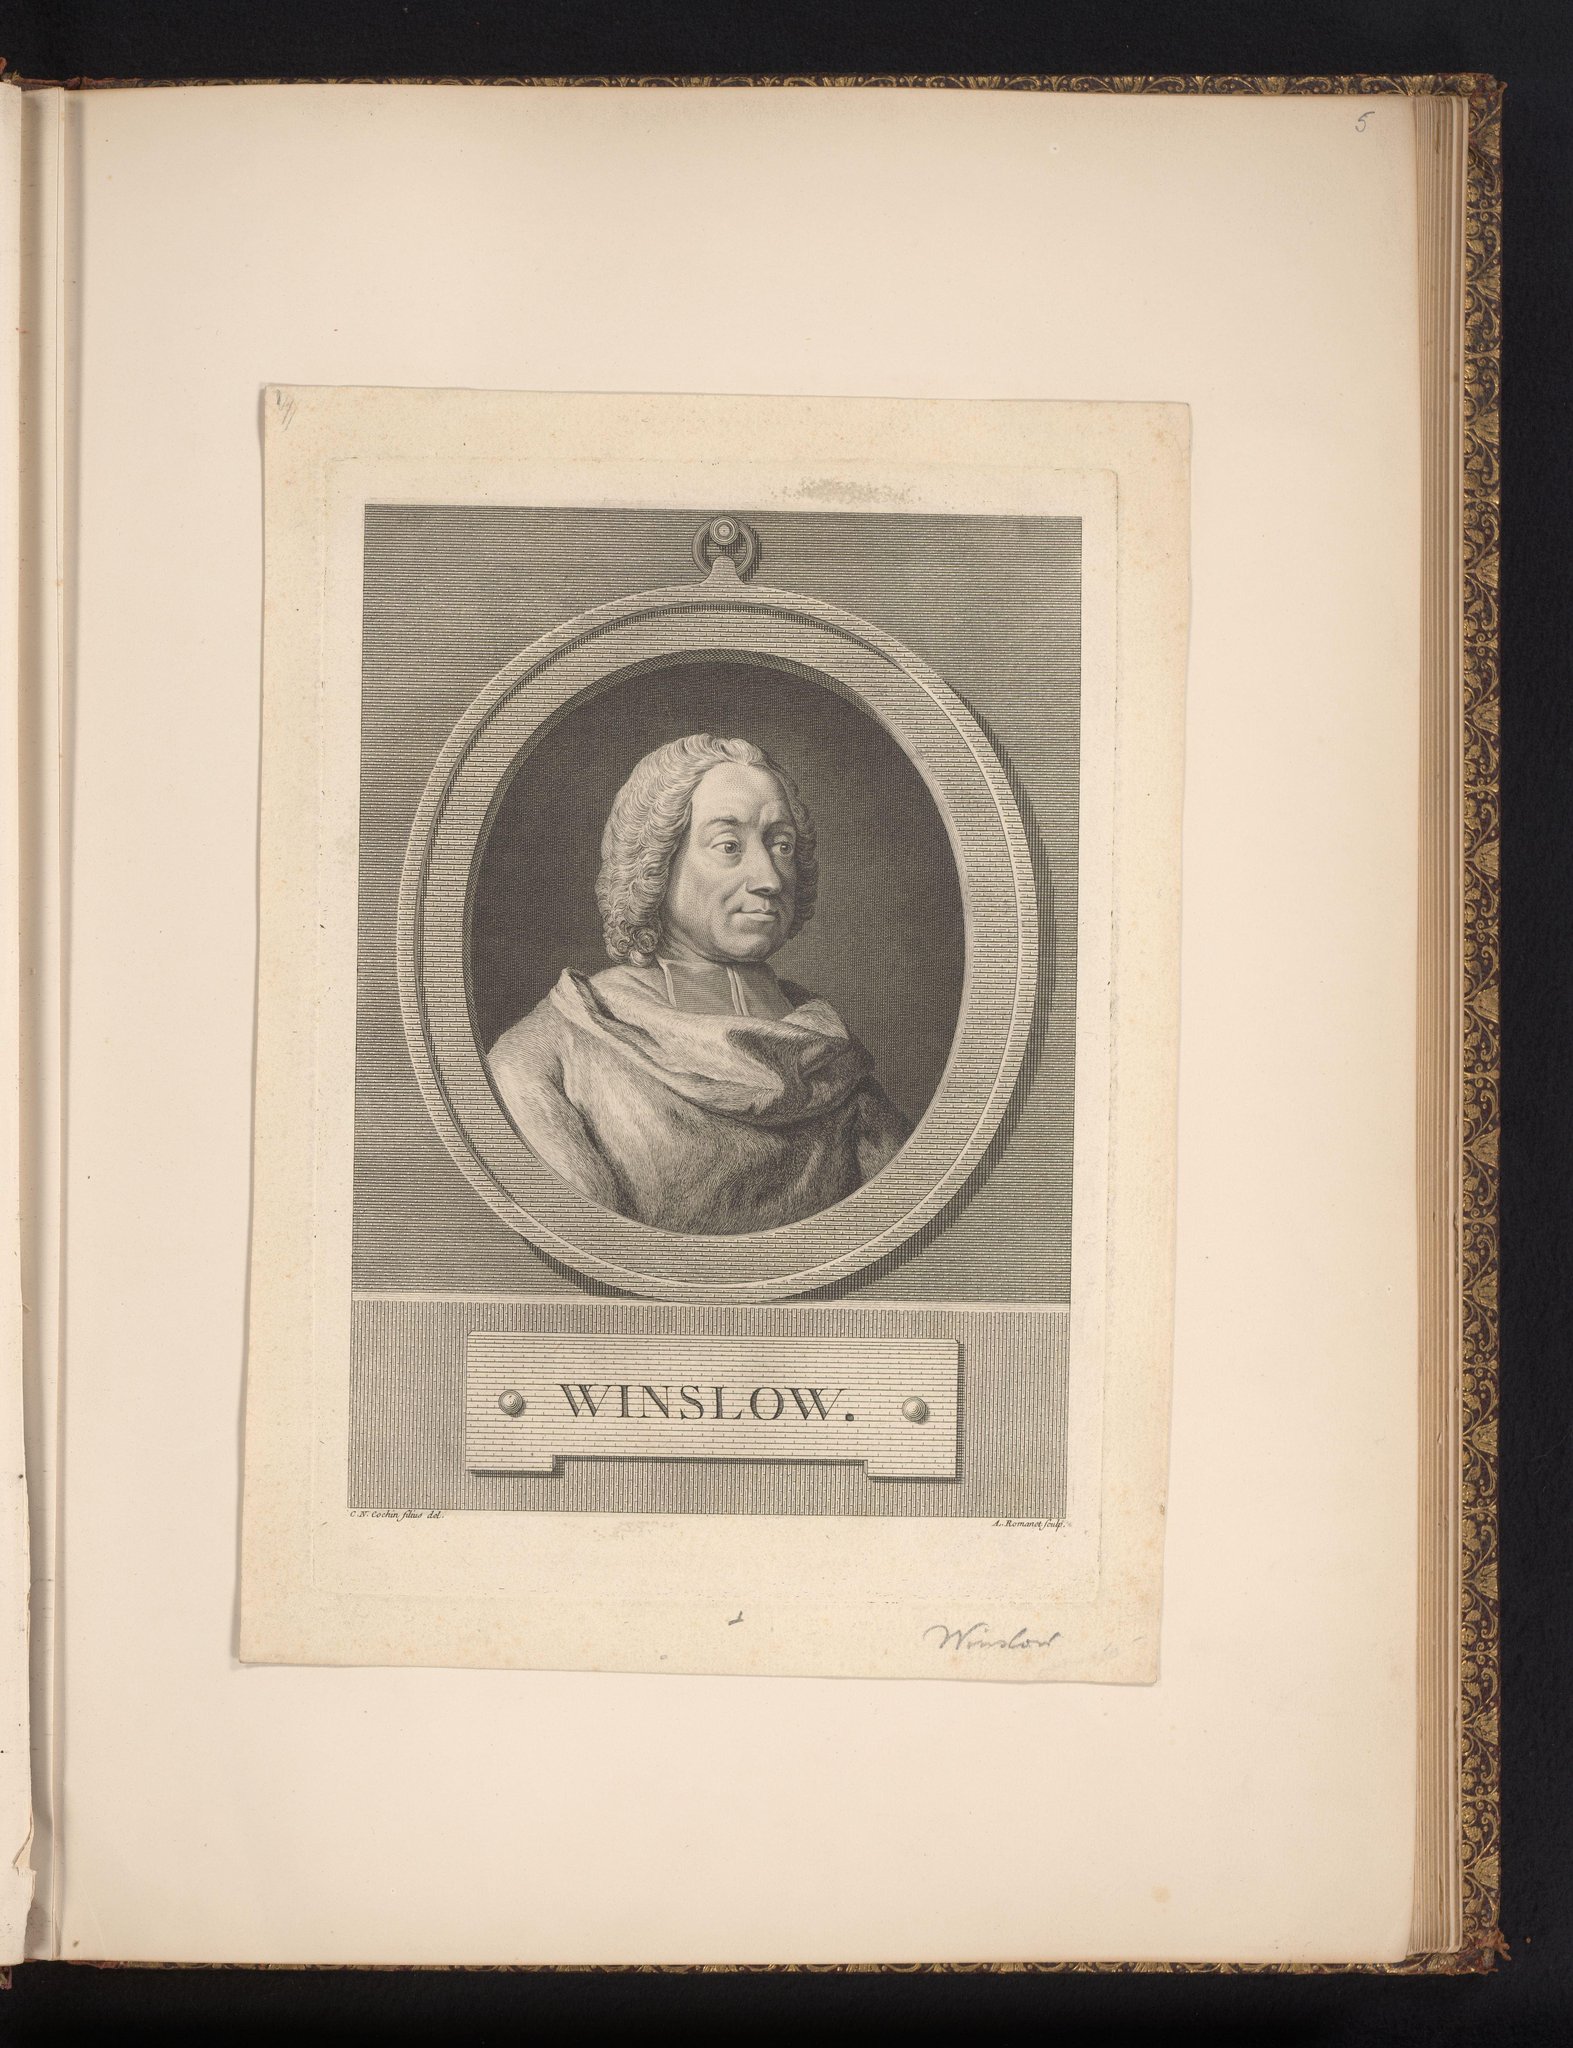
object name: print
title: Winslow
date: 1752-1810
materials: paper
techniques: engraving, etching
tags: historical persons, physician, doctor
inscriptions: annotation: ‘Winslow’